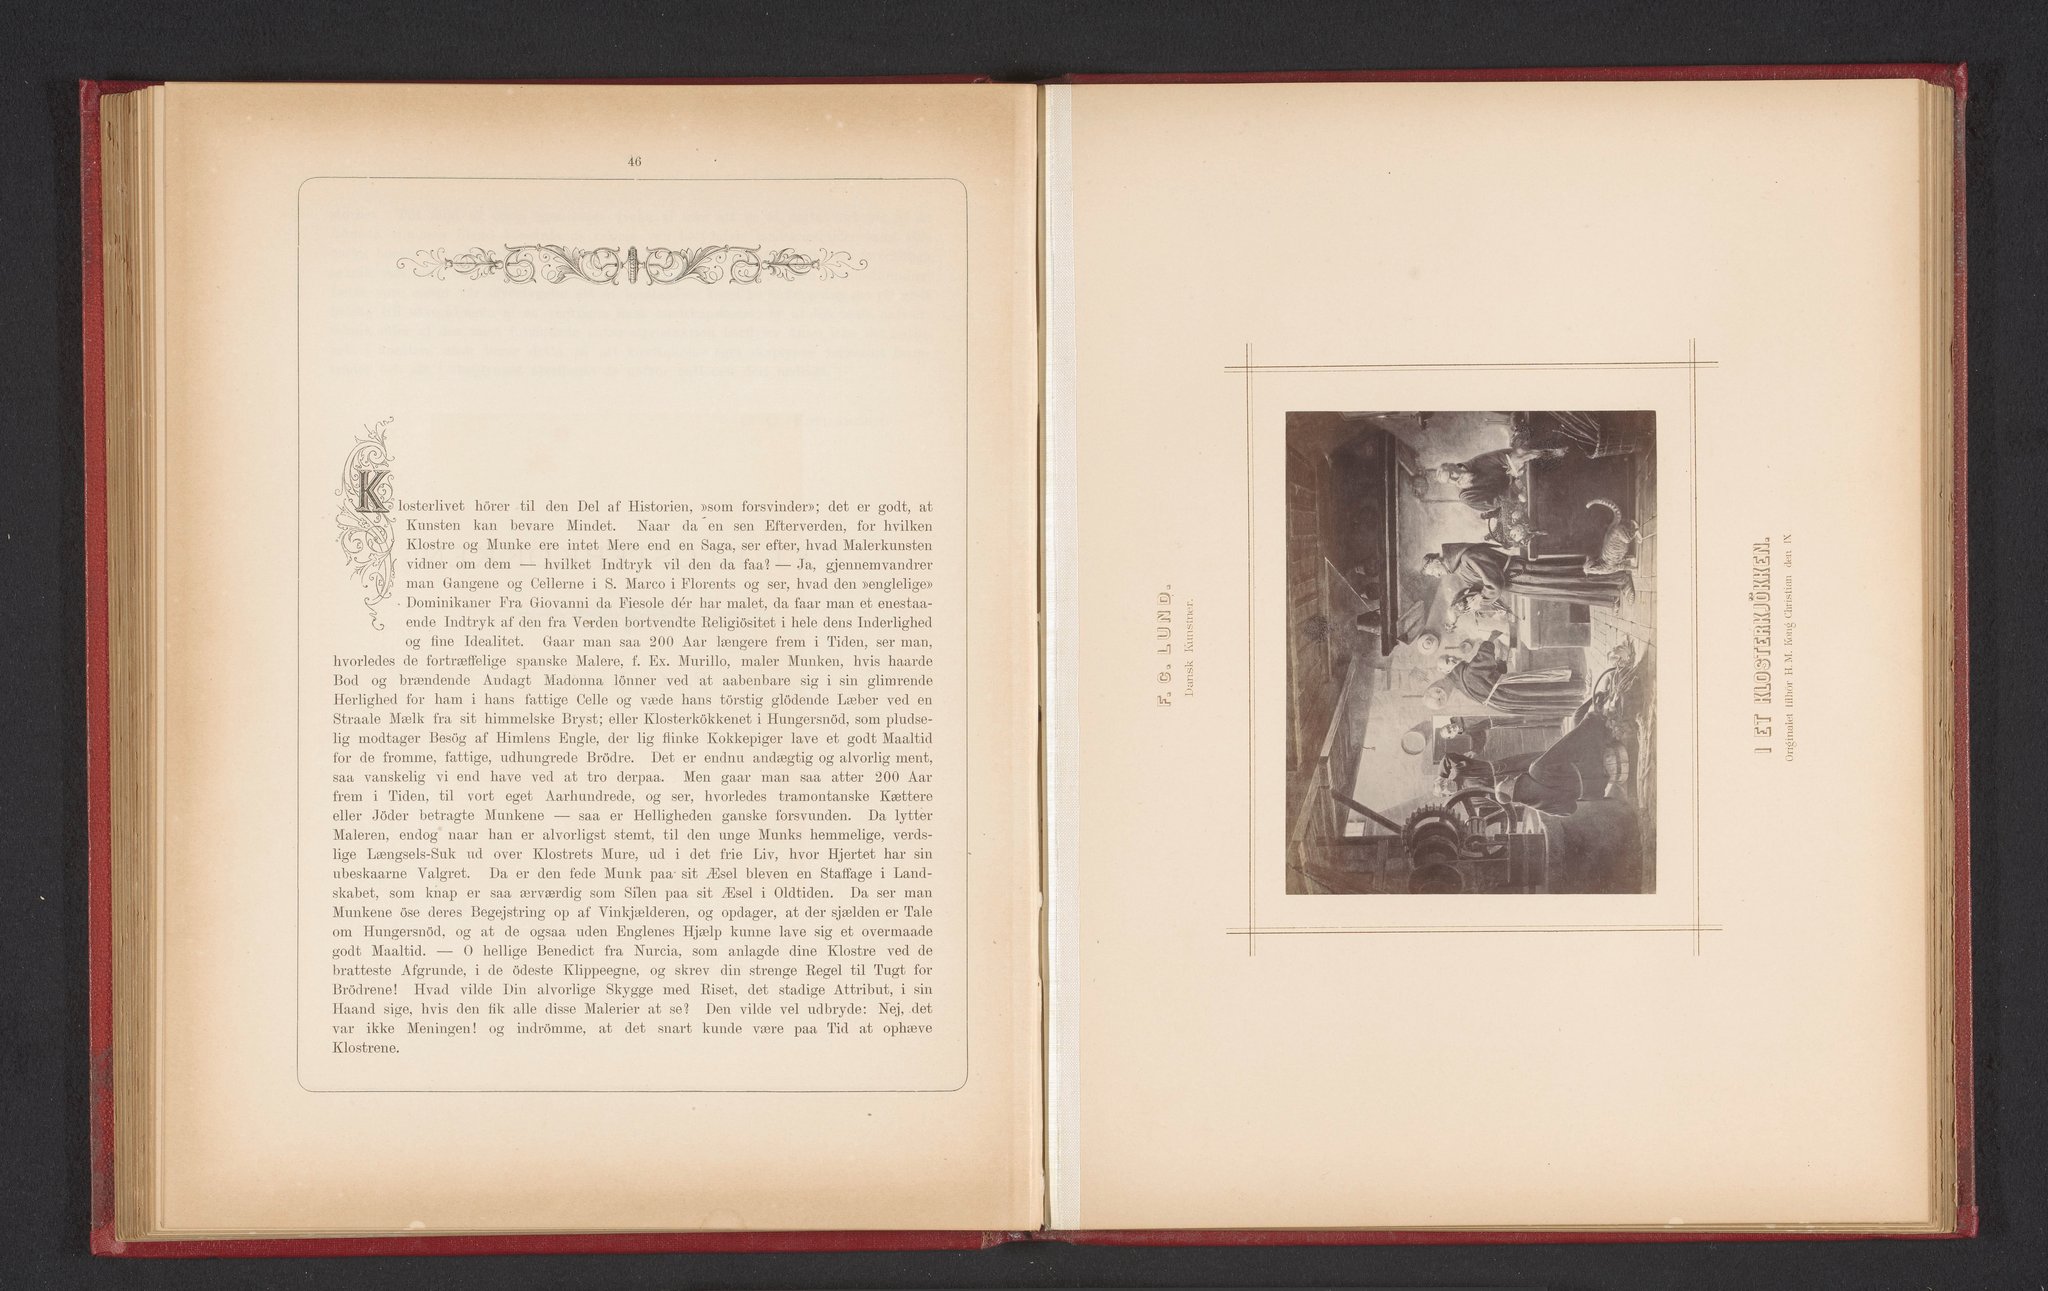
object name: page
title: Fotoreproductie van een schilderij van geestelijken in een kloosterkeuken door Frederik Christan Lund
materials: photographic support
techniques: albumen print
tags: kitchen, theologian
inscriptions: inscription: ‘Dansk Kunstner.’, inscription: ‘Originalet tilhör H. M. Kong Christian den IX.’